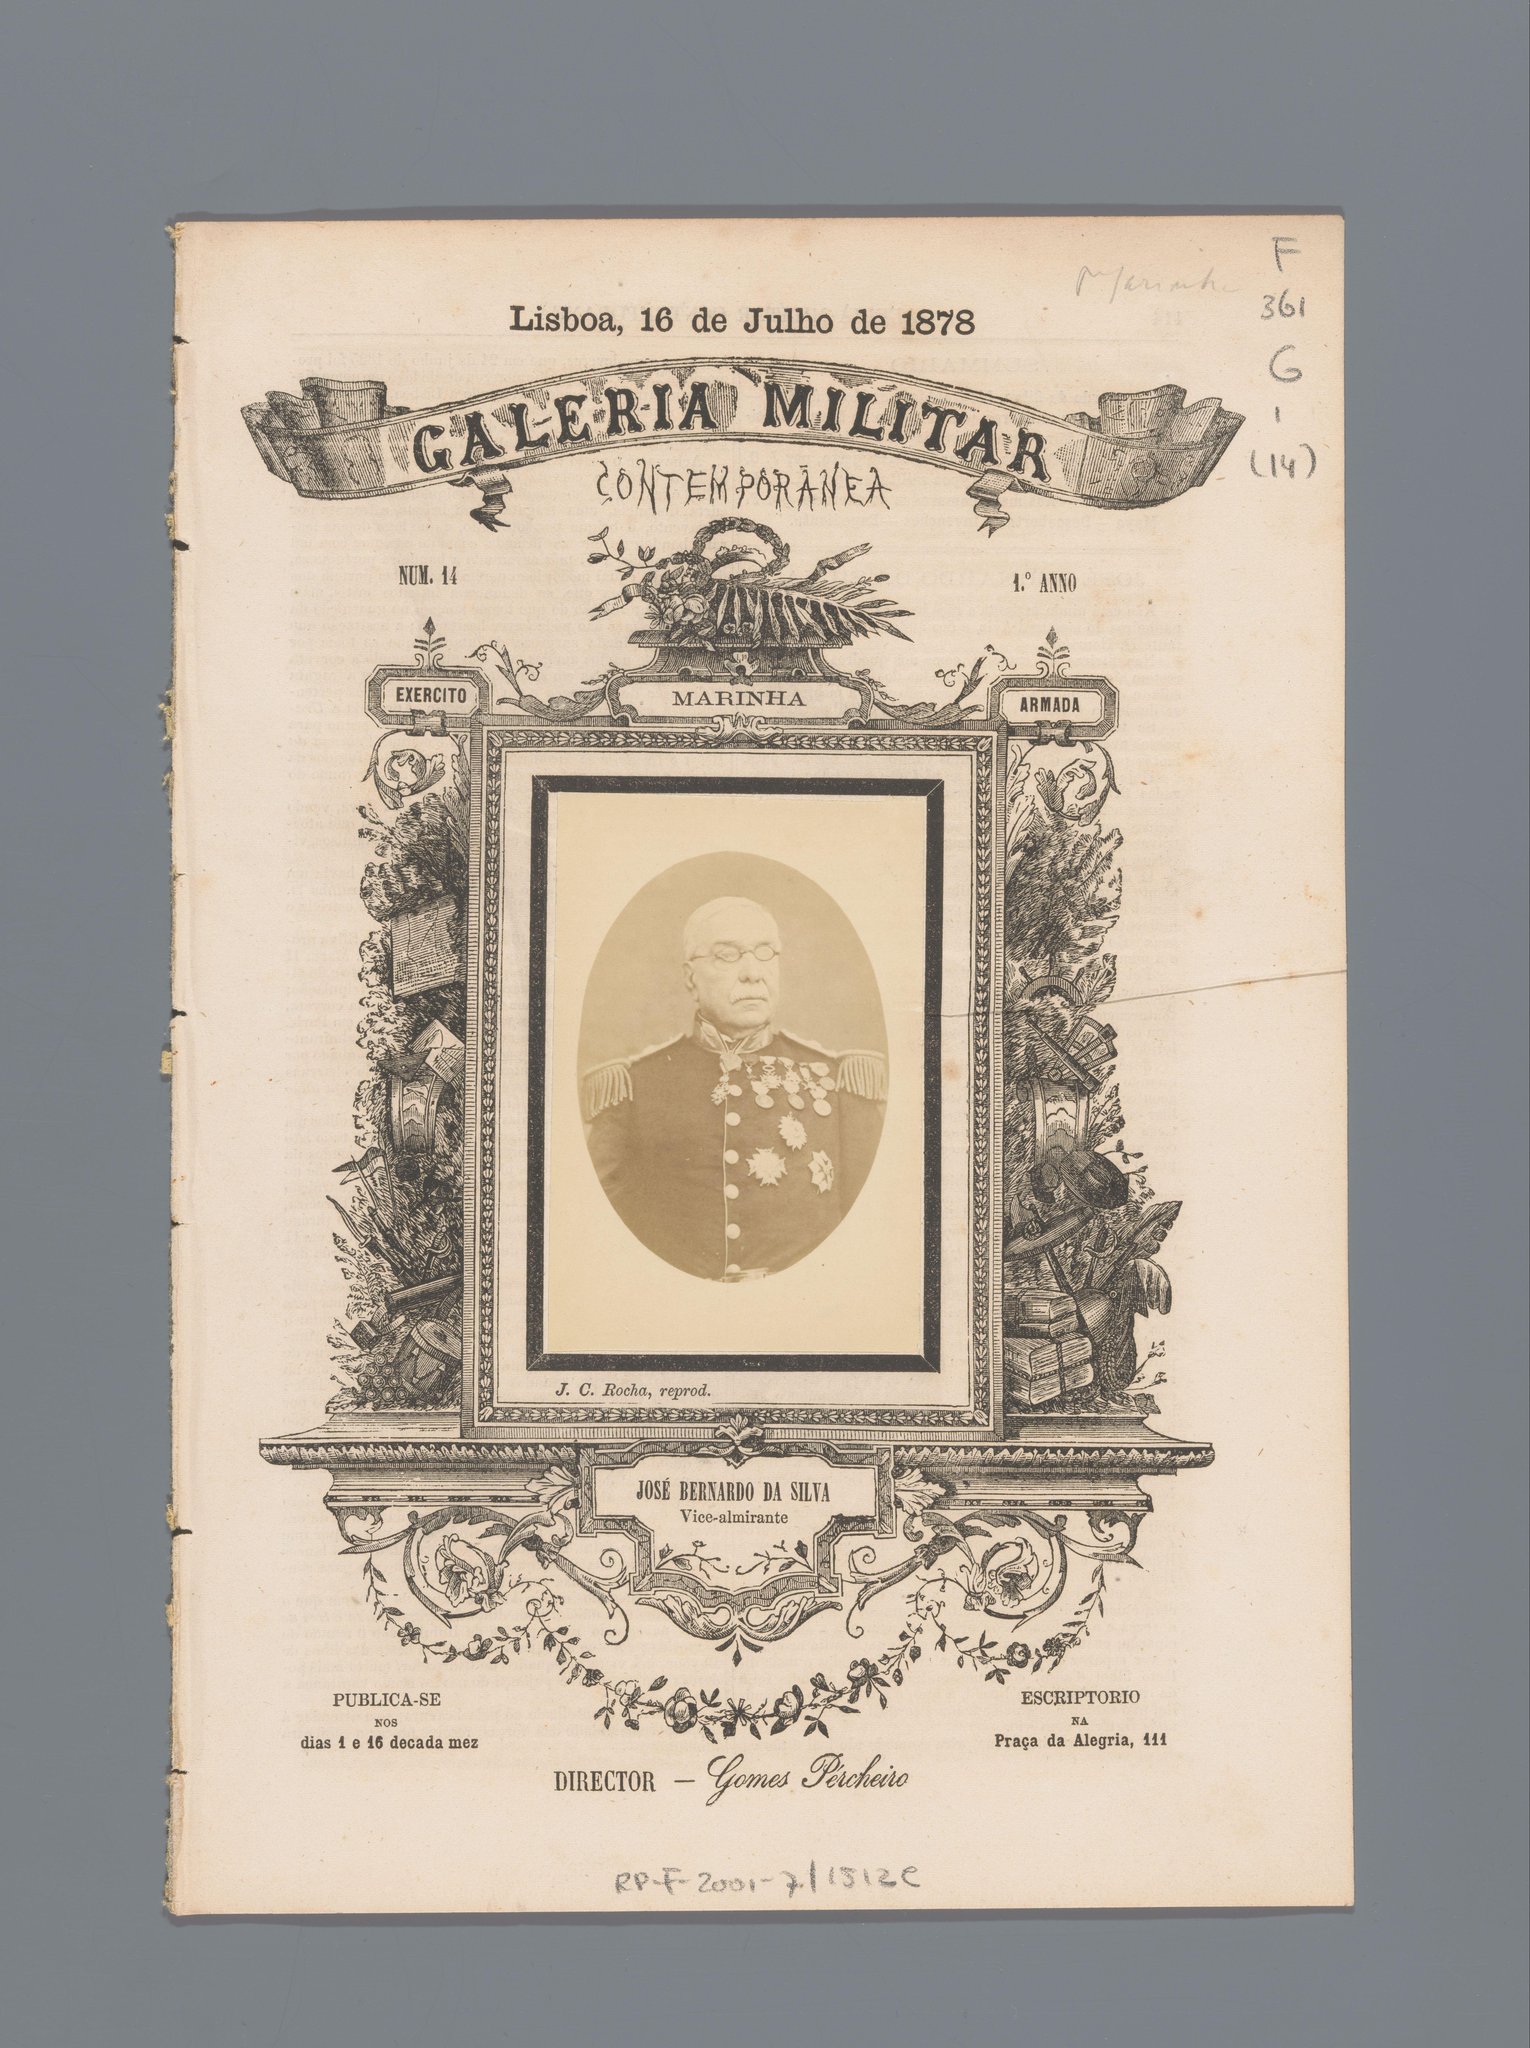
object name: photograph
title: José Bernardo da Silva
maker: j.c. rocha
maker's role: fotograaf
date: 1873-1878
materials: photographic support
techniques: albumen print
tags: historical persons, commander-in-chief, admiral